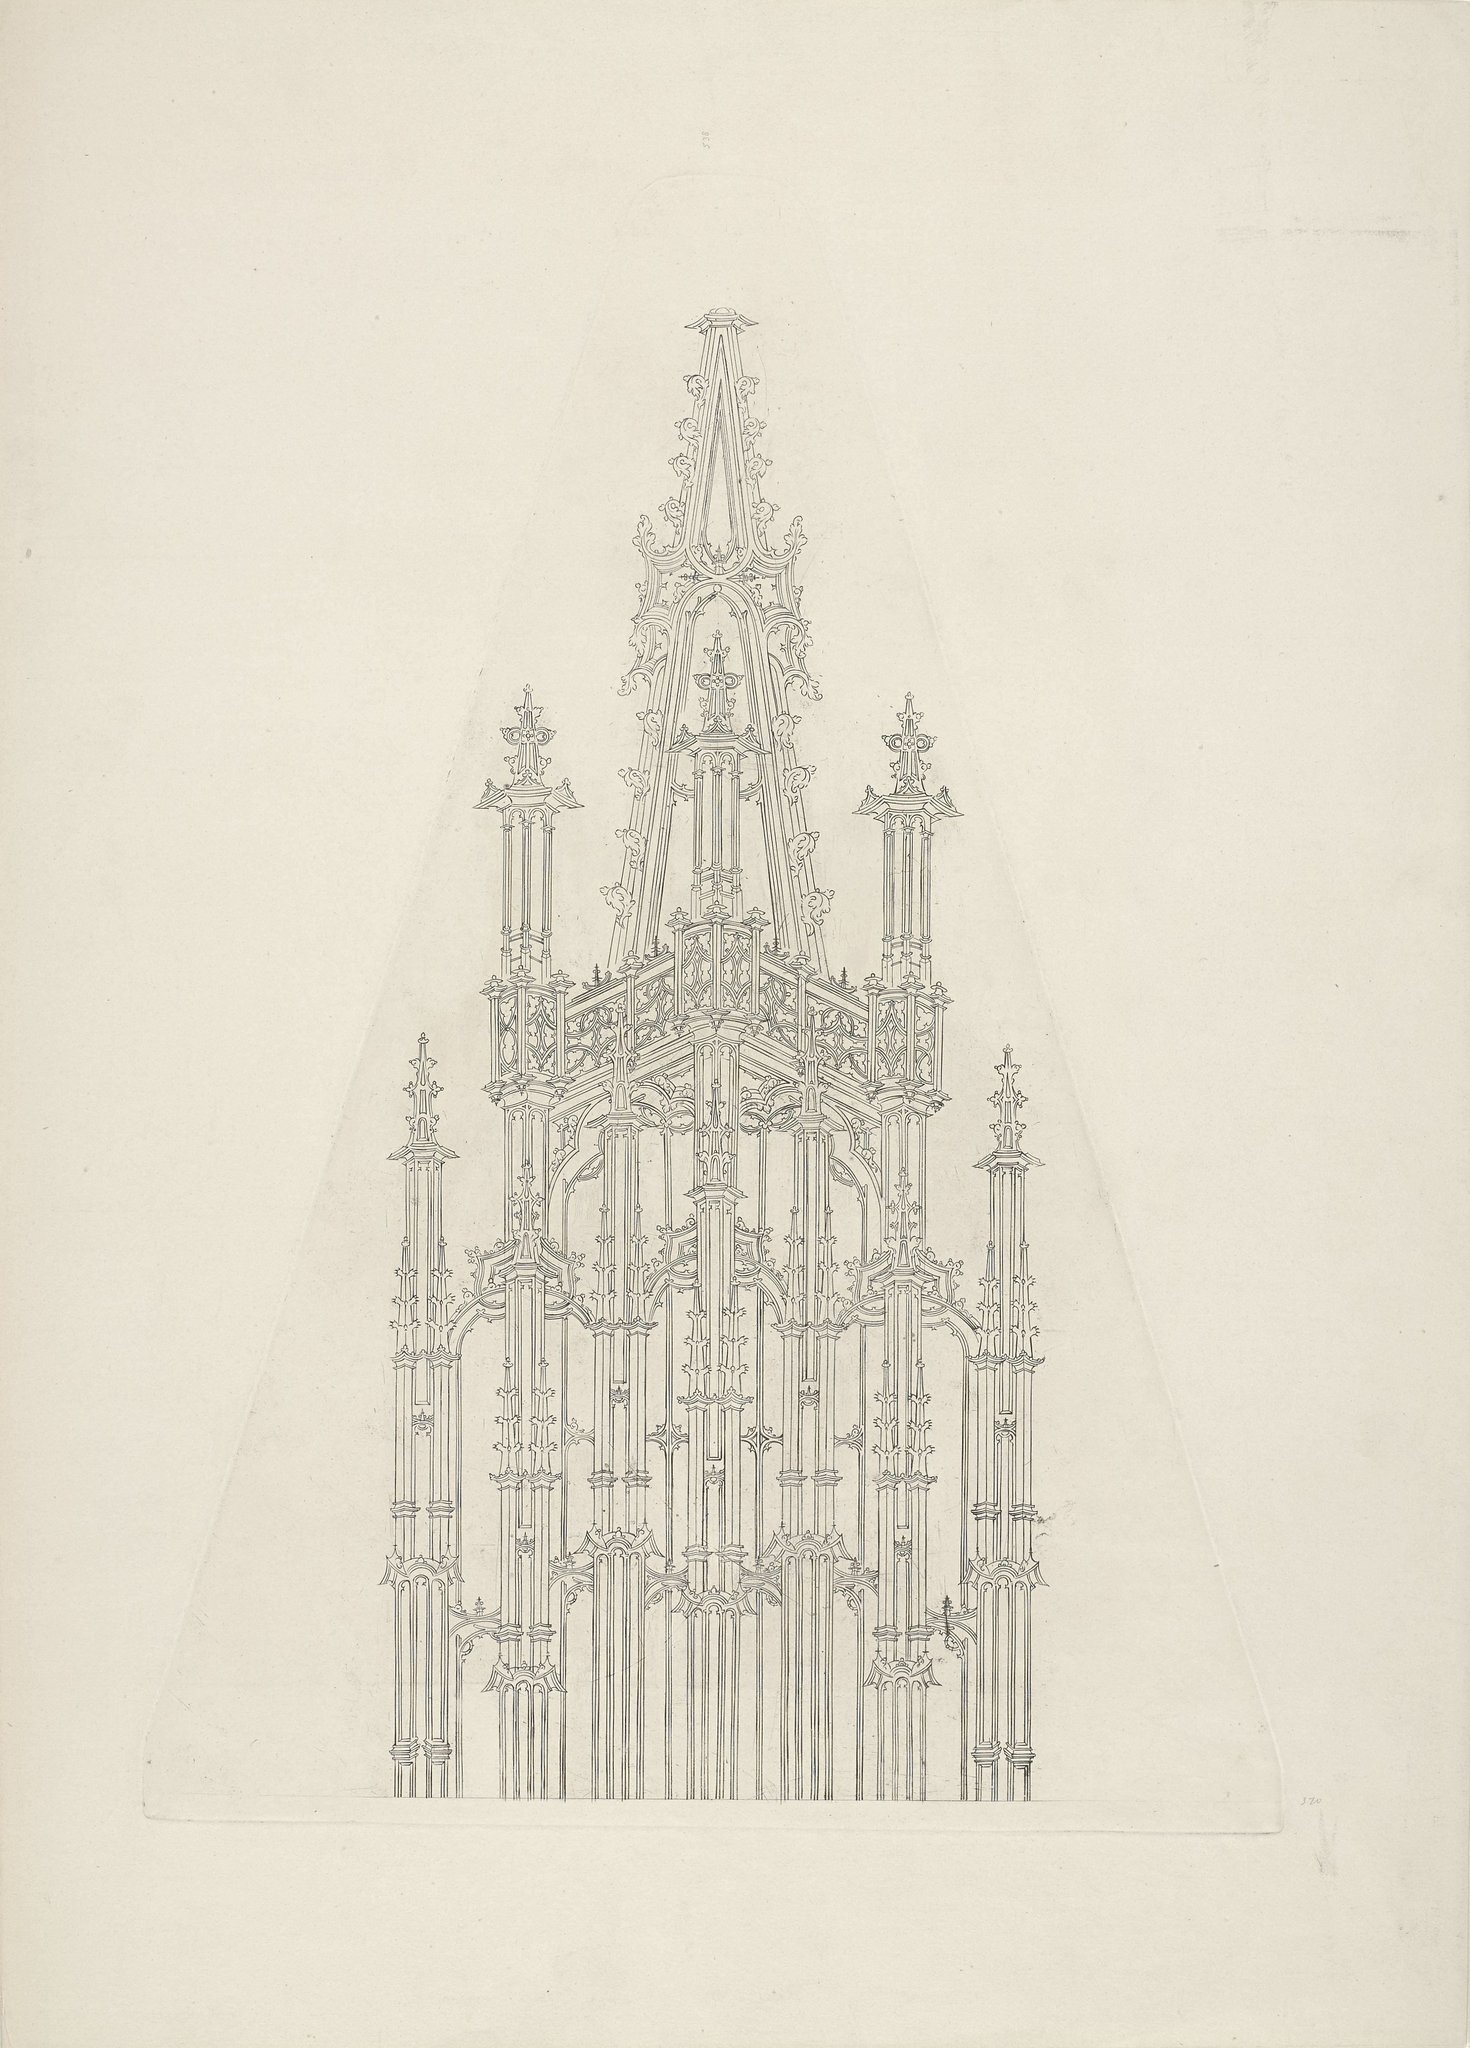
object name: print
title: Torenspits van de Sint Lievensmonsterkerk te Zierikzee, boven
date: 1619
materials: paper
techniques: engraving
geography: zierikzee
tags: parts of church exterior and annexes: tower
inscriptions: collector's mark: Lugt 2228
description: Ontwerp voor het bovenste gedeelte van de Sint Lievensmonstertoren.